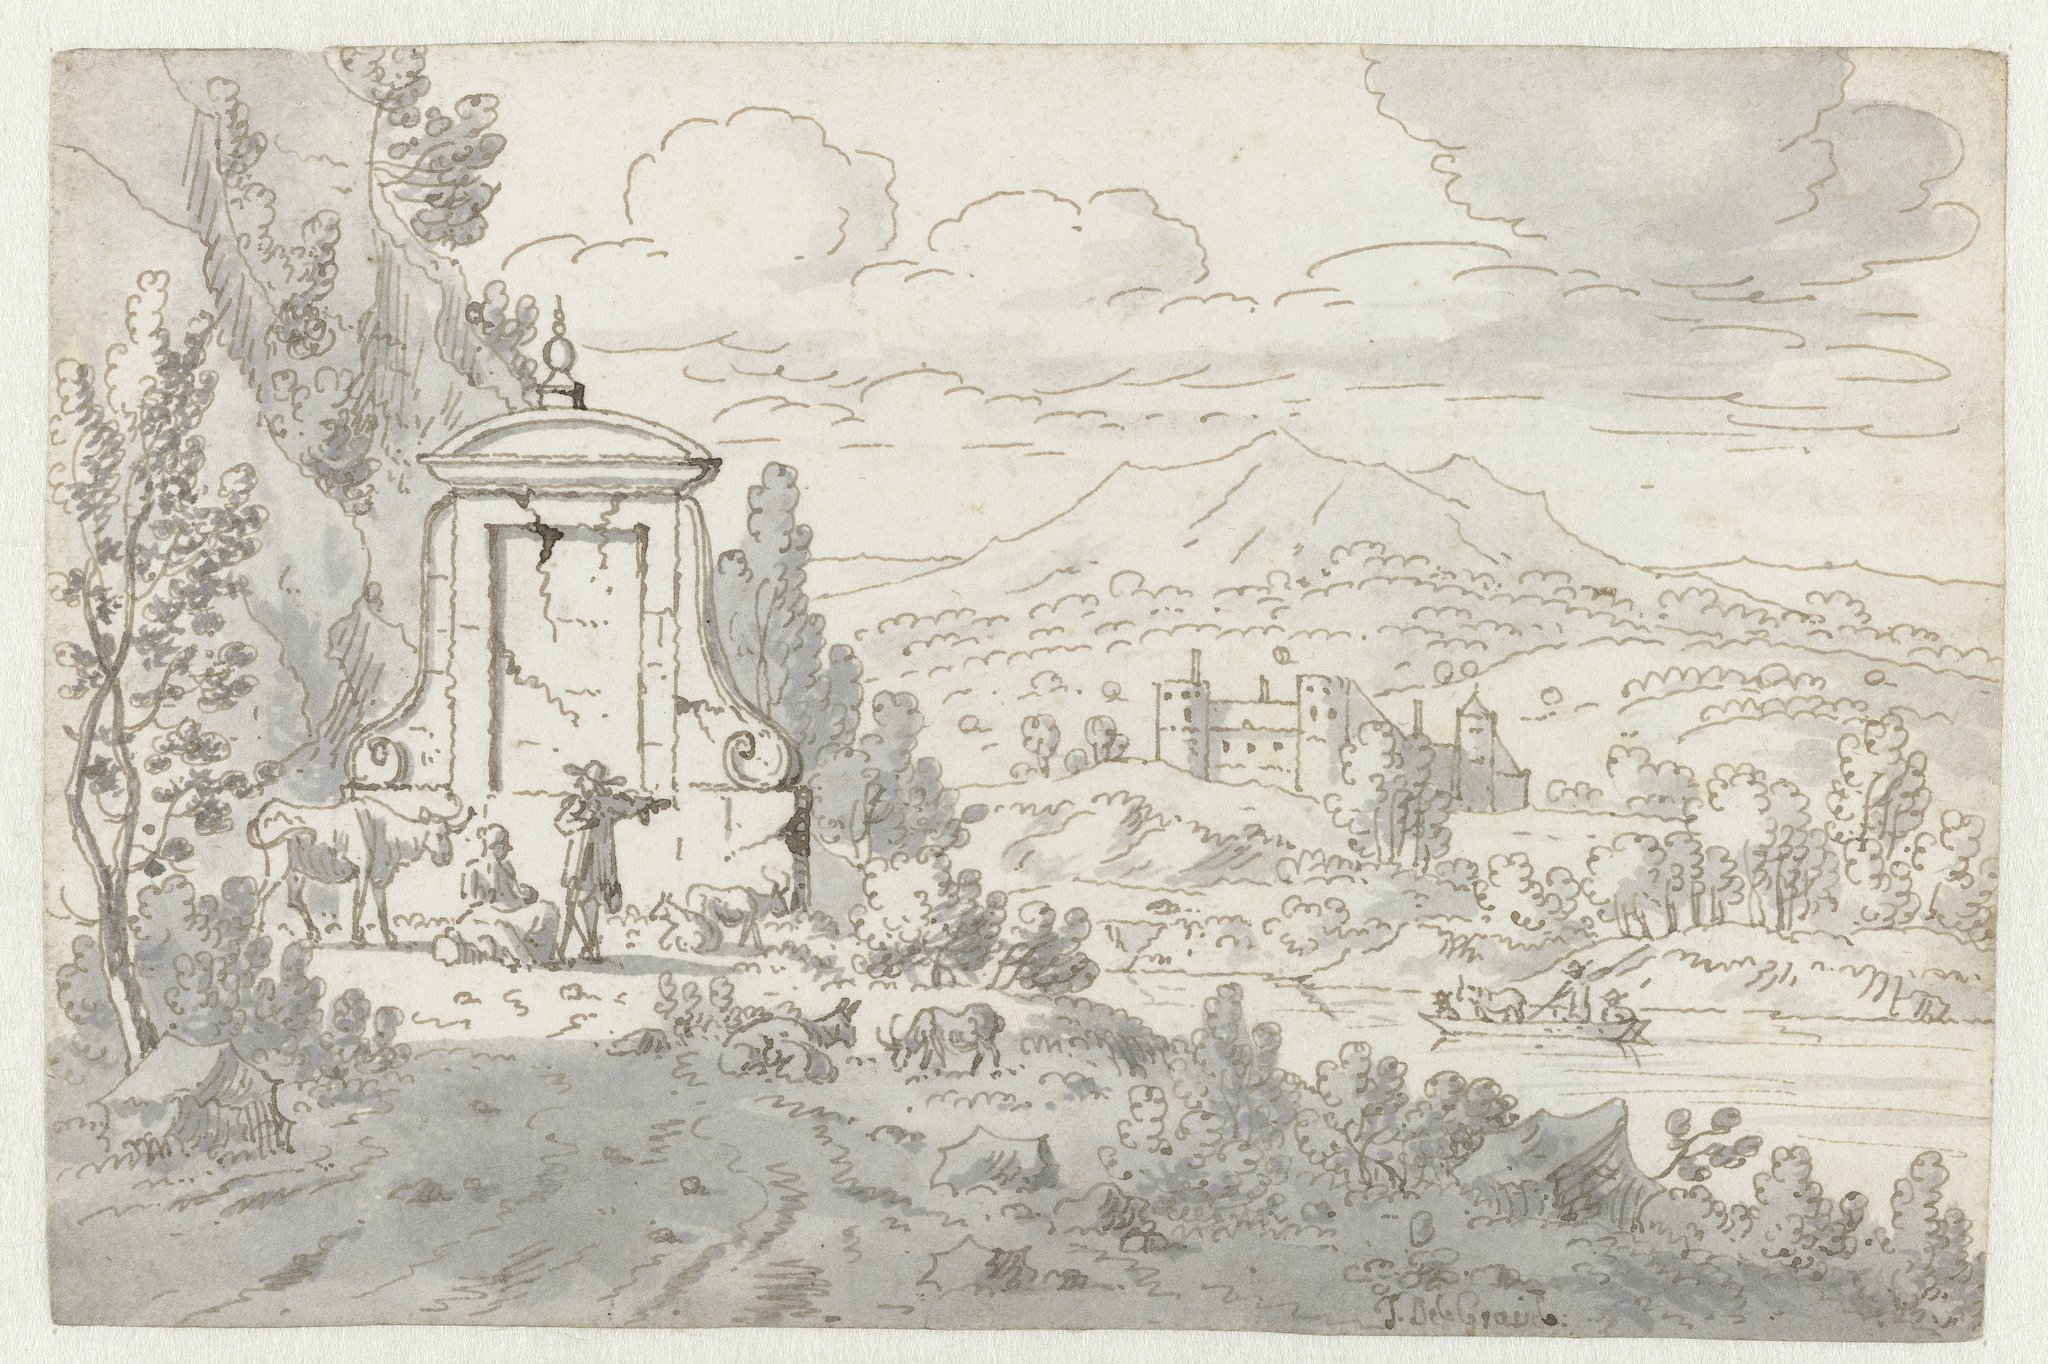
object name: drawing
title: Italianate River Landscape with Musicians, Shepherds and a Monument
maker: josua de grave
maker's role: draughtsman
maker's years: 1645-1712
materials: ink, paper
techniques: brush, pen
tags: occupations ~ cattle, prospect of city, town panorama, silhouette of city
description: Landschap met herders, een monument en een kasteel in de verte.